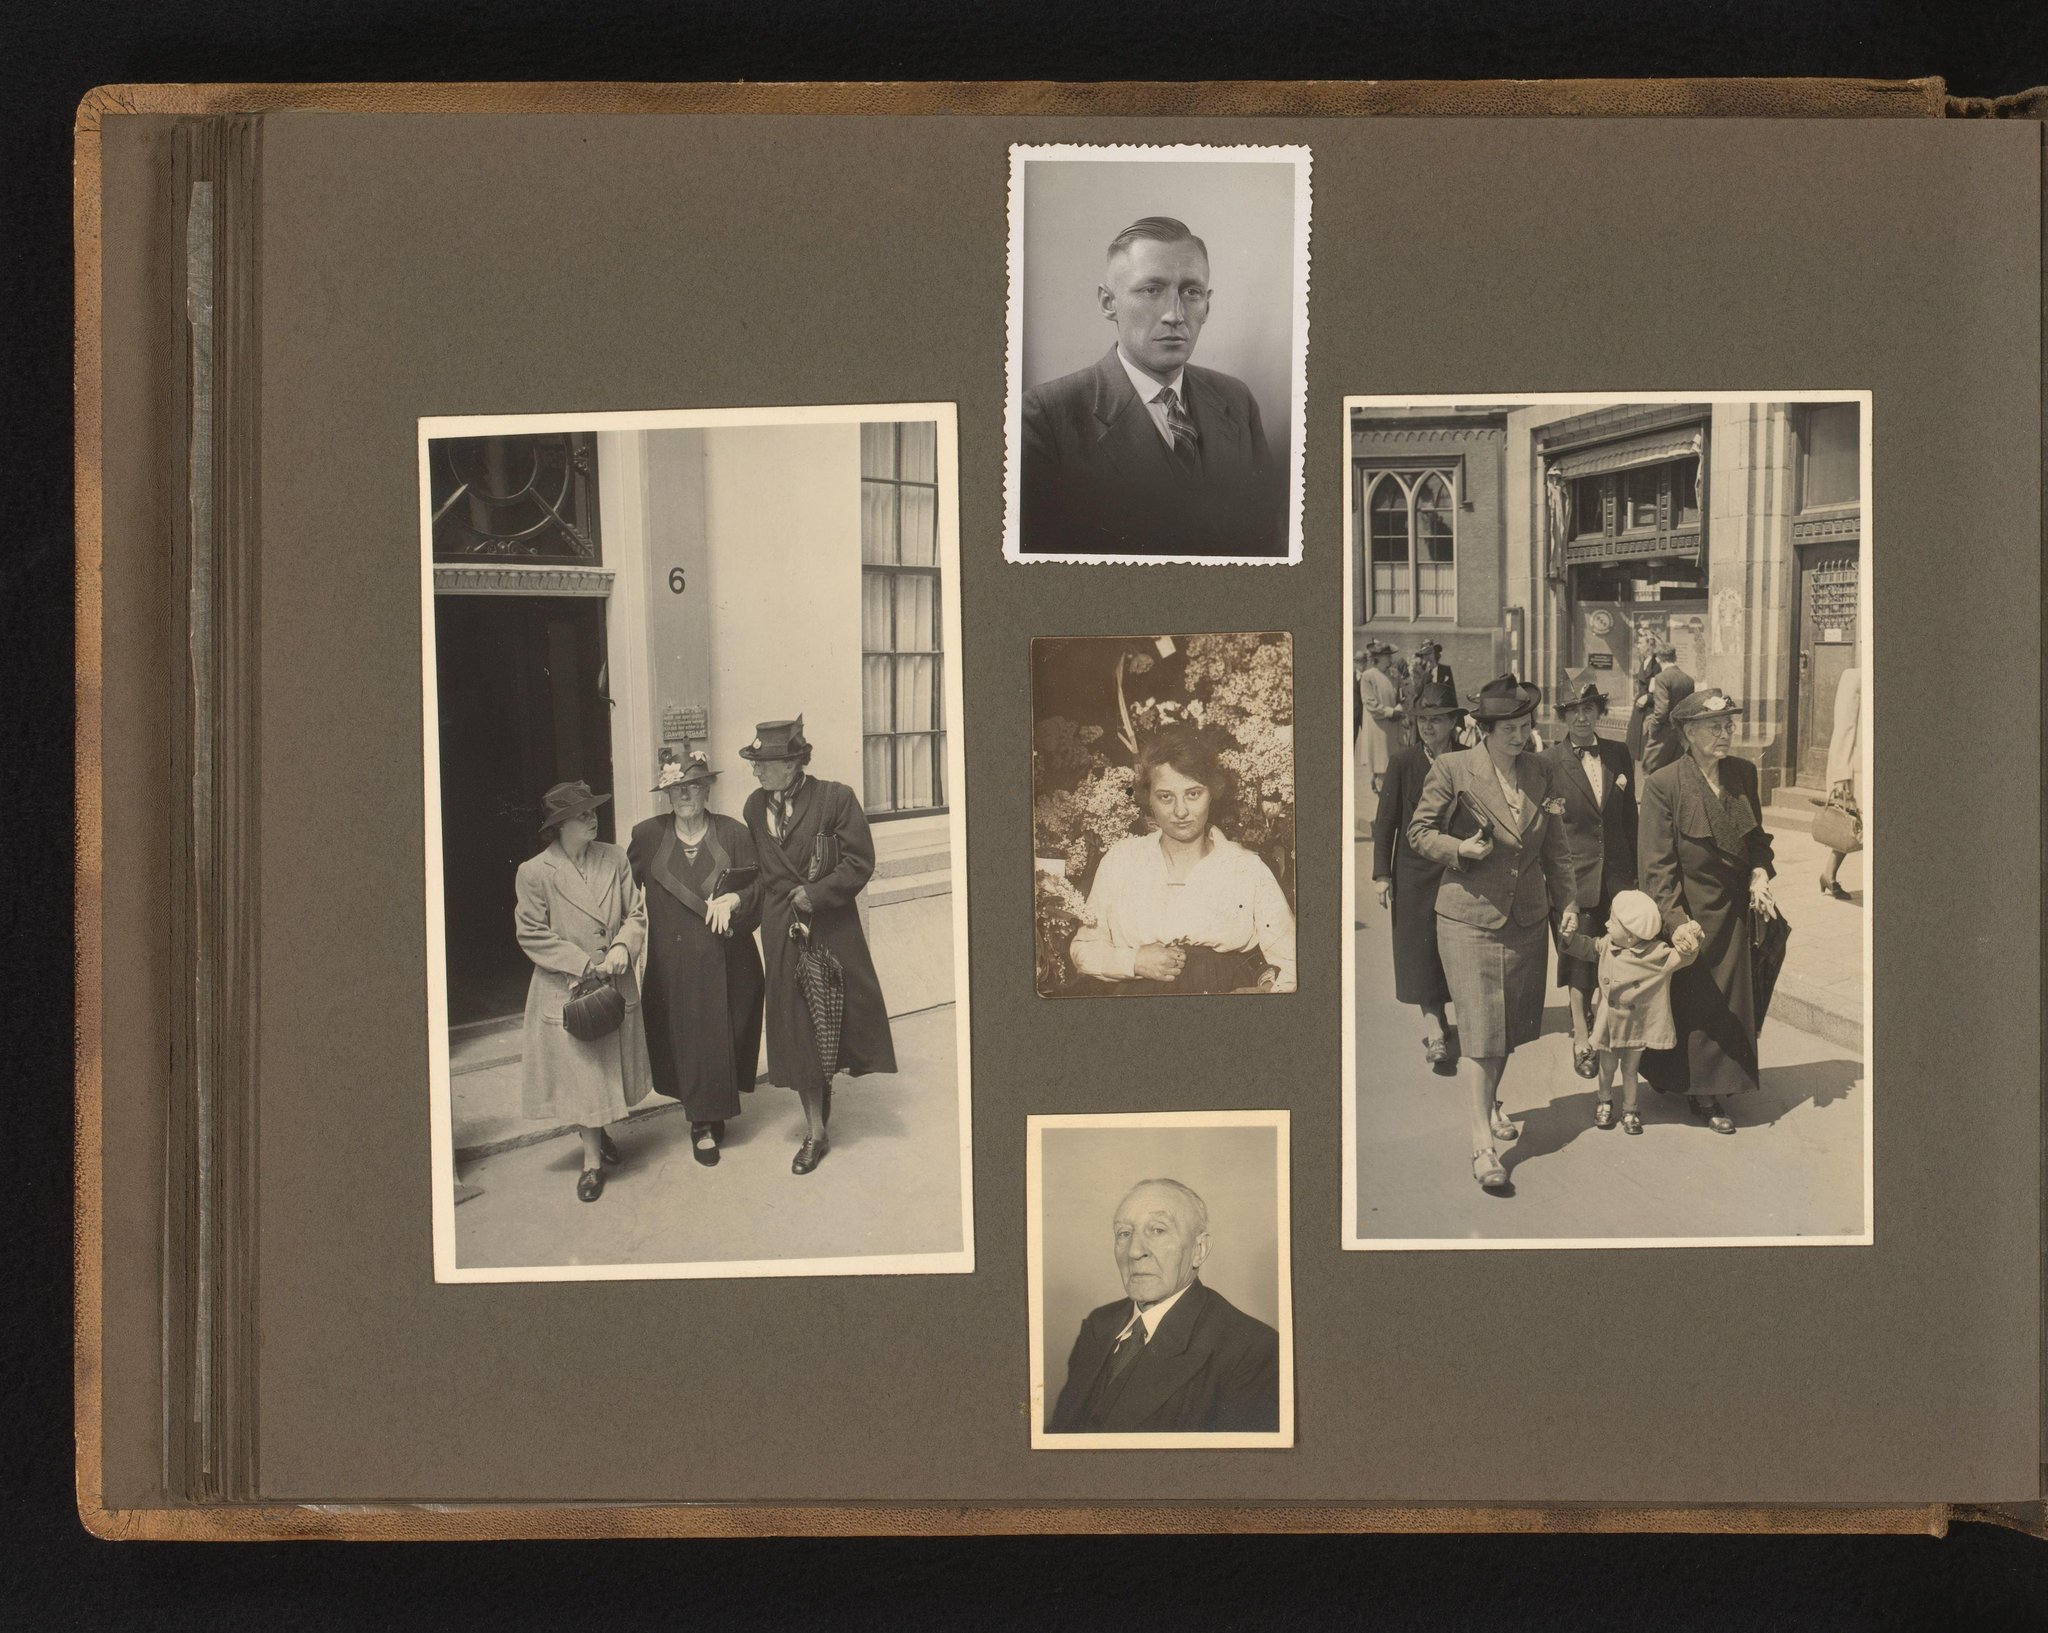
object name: album leaf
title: Portretten en personen op straat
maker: Anonymous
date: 1900-1950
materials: photographic support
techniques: gelatin silver print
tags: adult woman, adult man, historical persons, youth, adolescent, walking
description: Portretten van mannen en een portret van een vrouw en vrouwen op straat. Deze pagina maakt deel uit van een album.